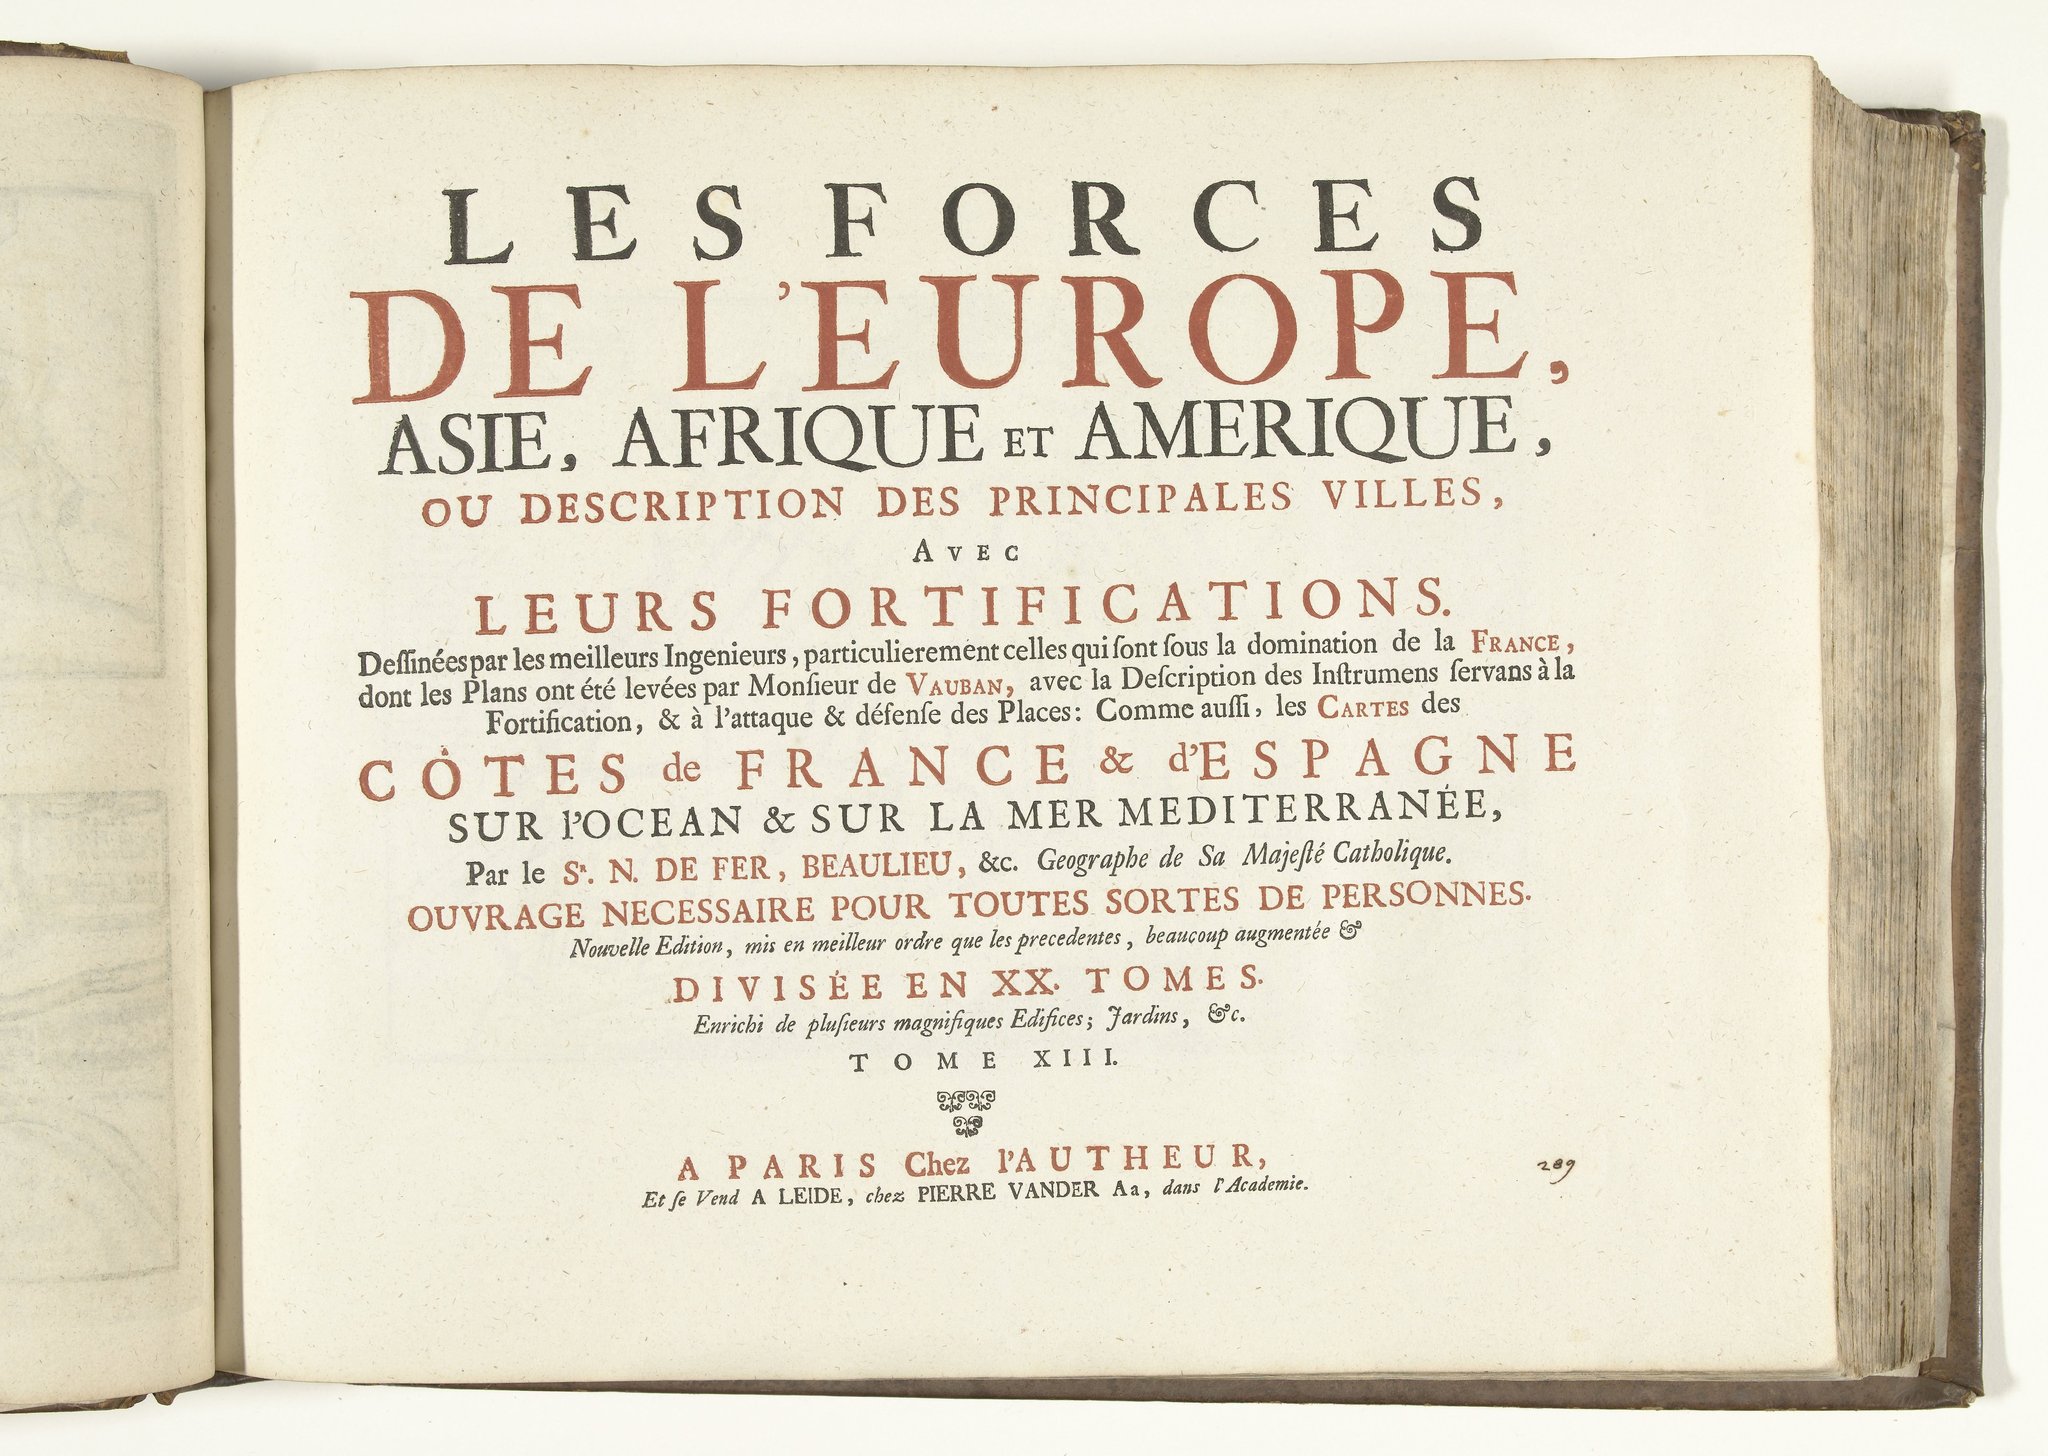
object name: titelblad, titelpagina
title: Titelpagina voor het prentwerk: Les Forces de l'Europe, Asie, Afrique et Amerique (...) Comme aussi les Cartes des Côtes de France et d'Espagne (deel XIII), 1726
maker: pieter van der aa (i)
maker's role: printer, publisher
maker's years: 1659-1733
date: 1726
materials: paper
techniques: letterpress printing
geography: leiden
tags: spaanse successieoorlog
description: Titelpagina gedrukt in zwart en rood voor deel XIII van het prentwerk Les Forces de l'Europe, Asie, Afrique et Amerique ... Comme aussi les Cartes des Côtes de France et d'Espagne, 1726. Dit tweede deel van het prentwerk bestaat uit 271 met de hand genummerde platen van vermaarde sterke steden en vestingen in het kader van de Spaanse Successieoorlog 1701-1713. Voor het merendeel zijn deze platen gekopieerd naar de anonieme Franse platen van vermaarde sterke steden en vestingen: in Les forces de l'Europe en in: Le theatre de la guerre, dans les Pays-Bas, beide oorspronkelijk uitgegeven door Nicolas de Fer te Parijs (1693-1697) in het kader van de Negenjarige Oorlog. Titel in het Frans.